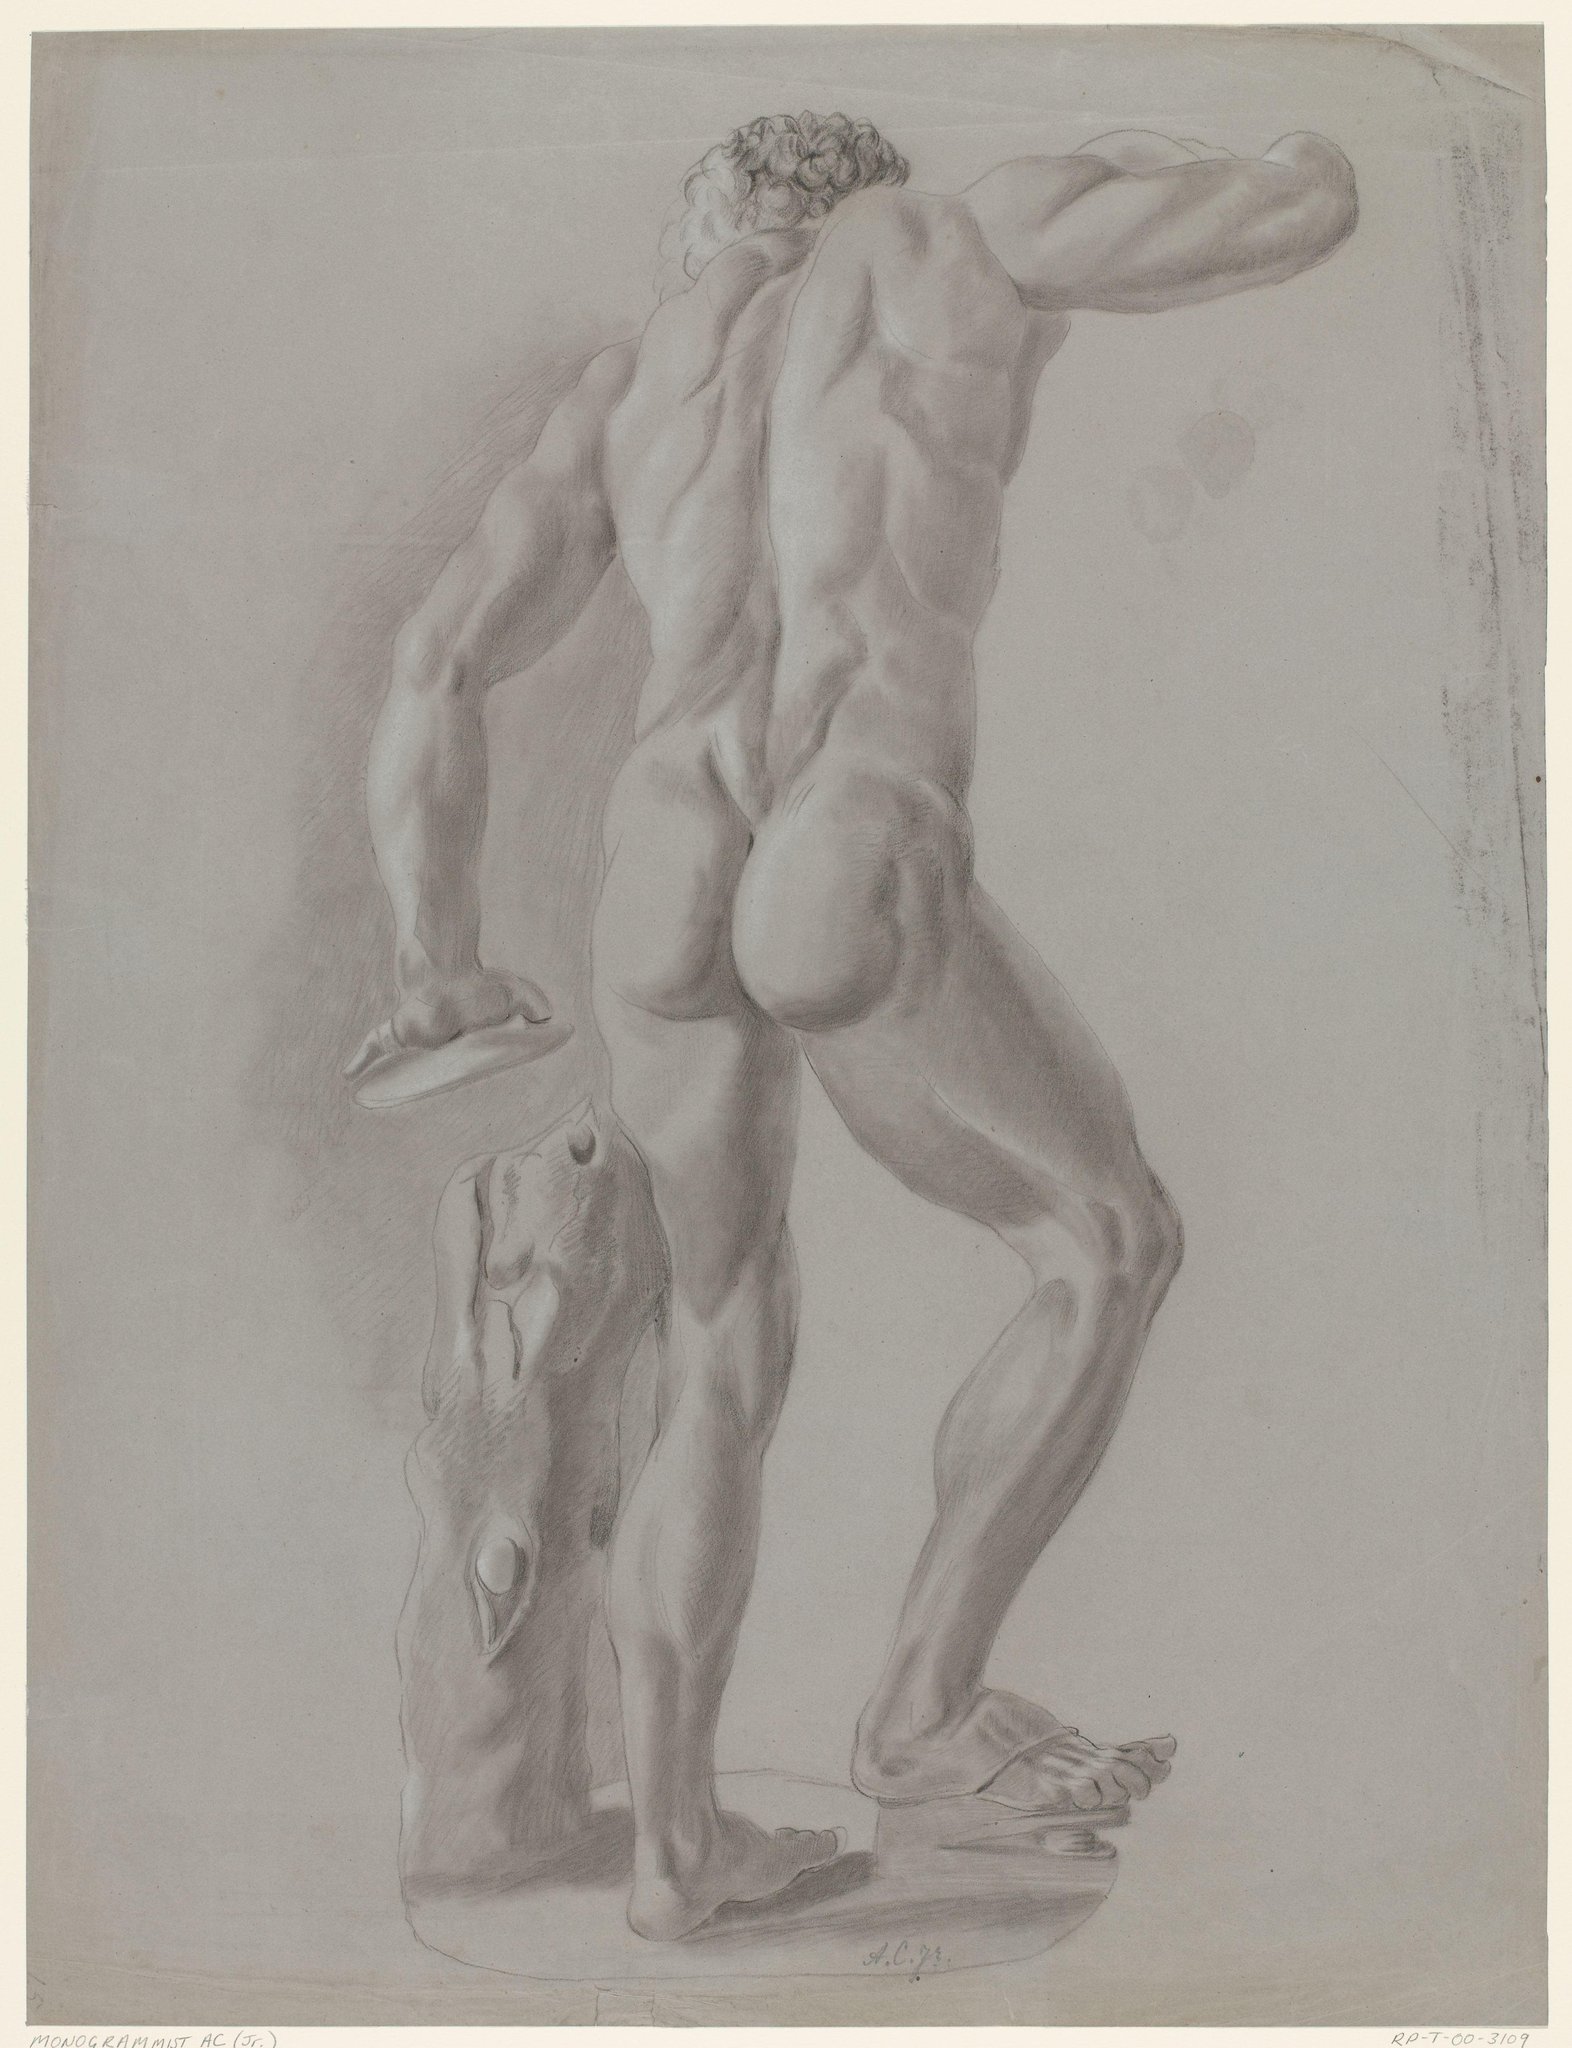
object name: drawing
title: Bacchant, op de rug gezien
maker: monogrammist ac (jr.)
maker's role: draughtsman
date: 1800-1900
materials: chalk, paper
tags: piece of sculpture, reproduction of a piece of sculpture (+ ceramics ~ arts)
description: Studie naar gips van een bacchant, op de rug gezien.